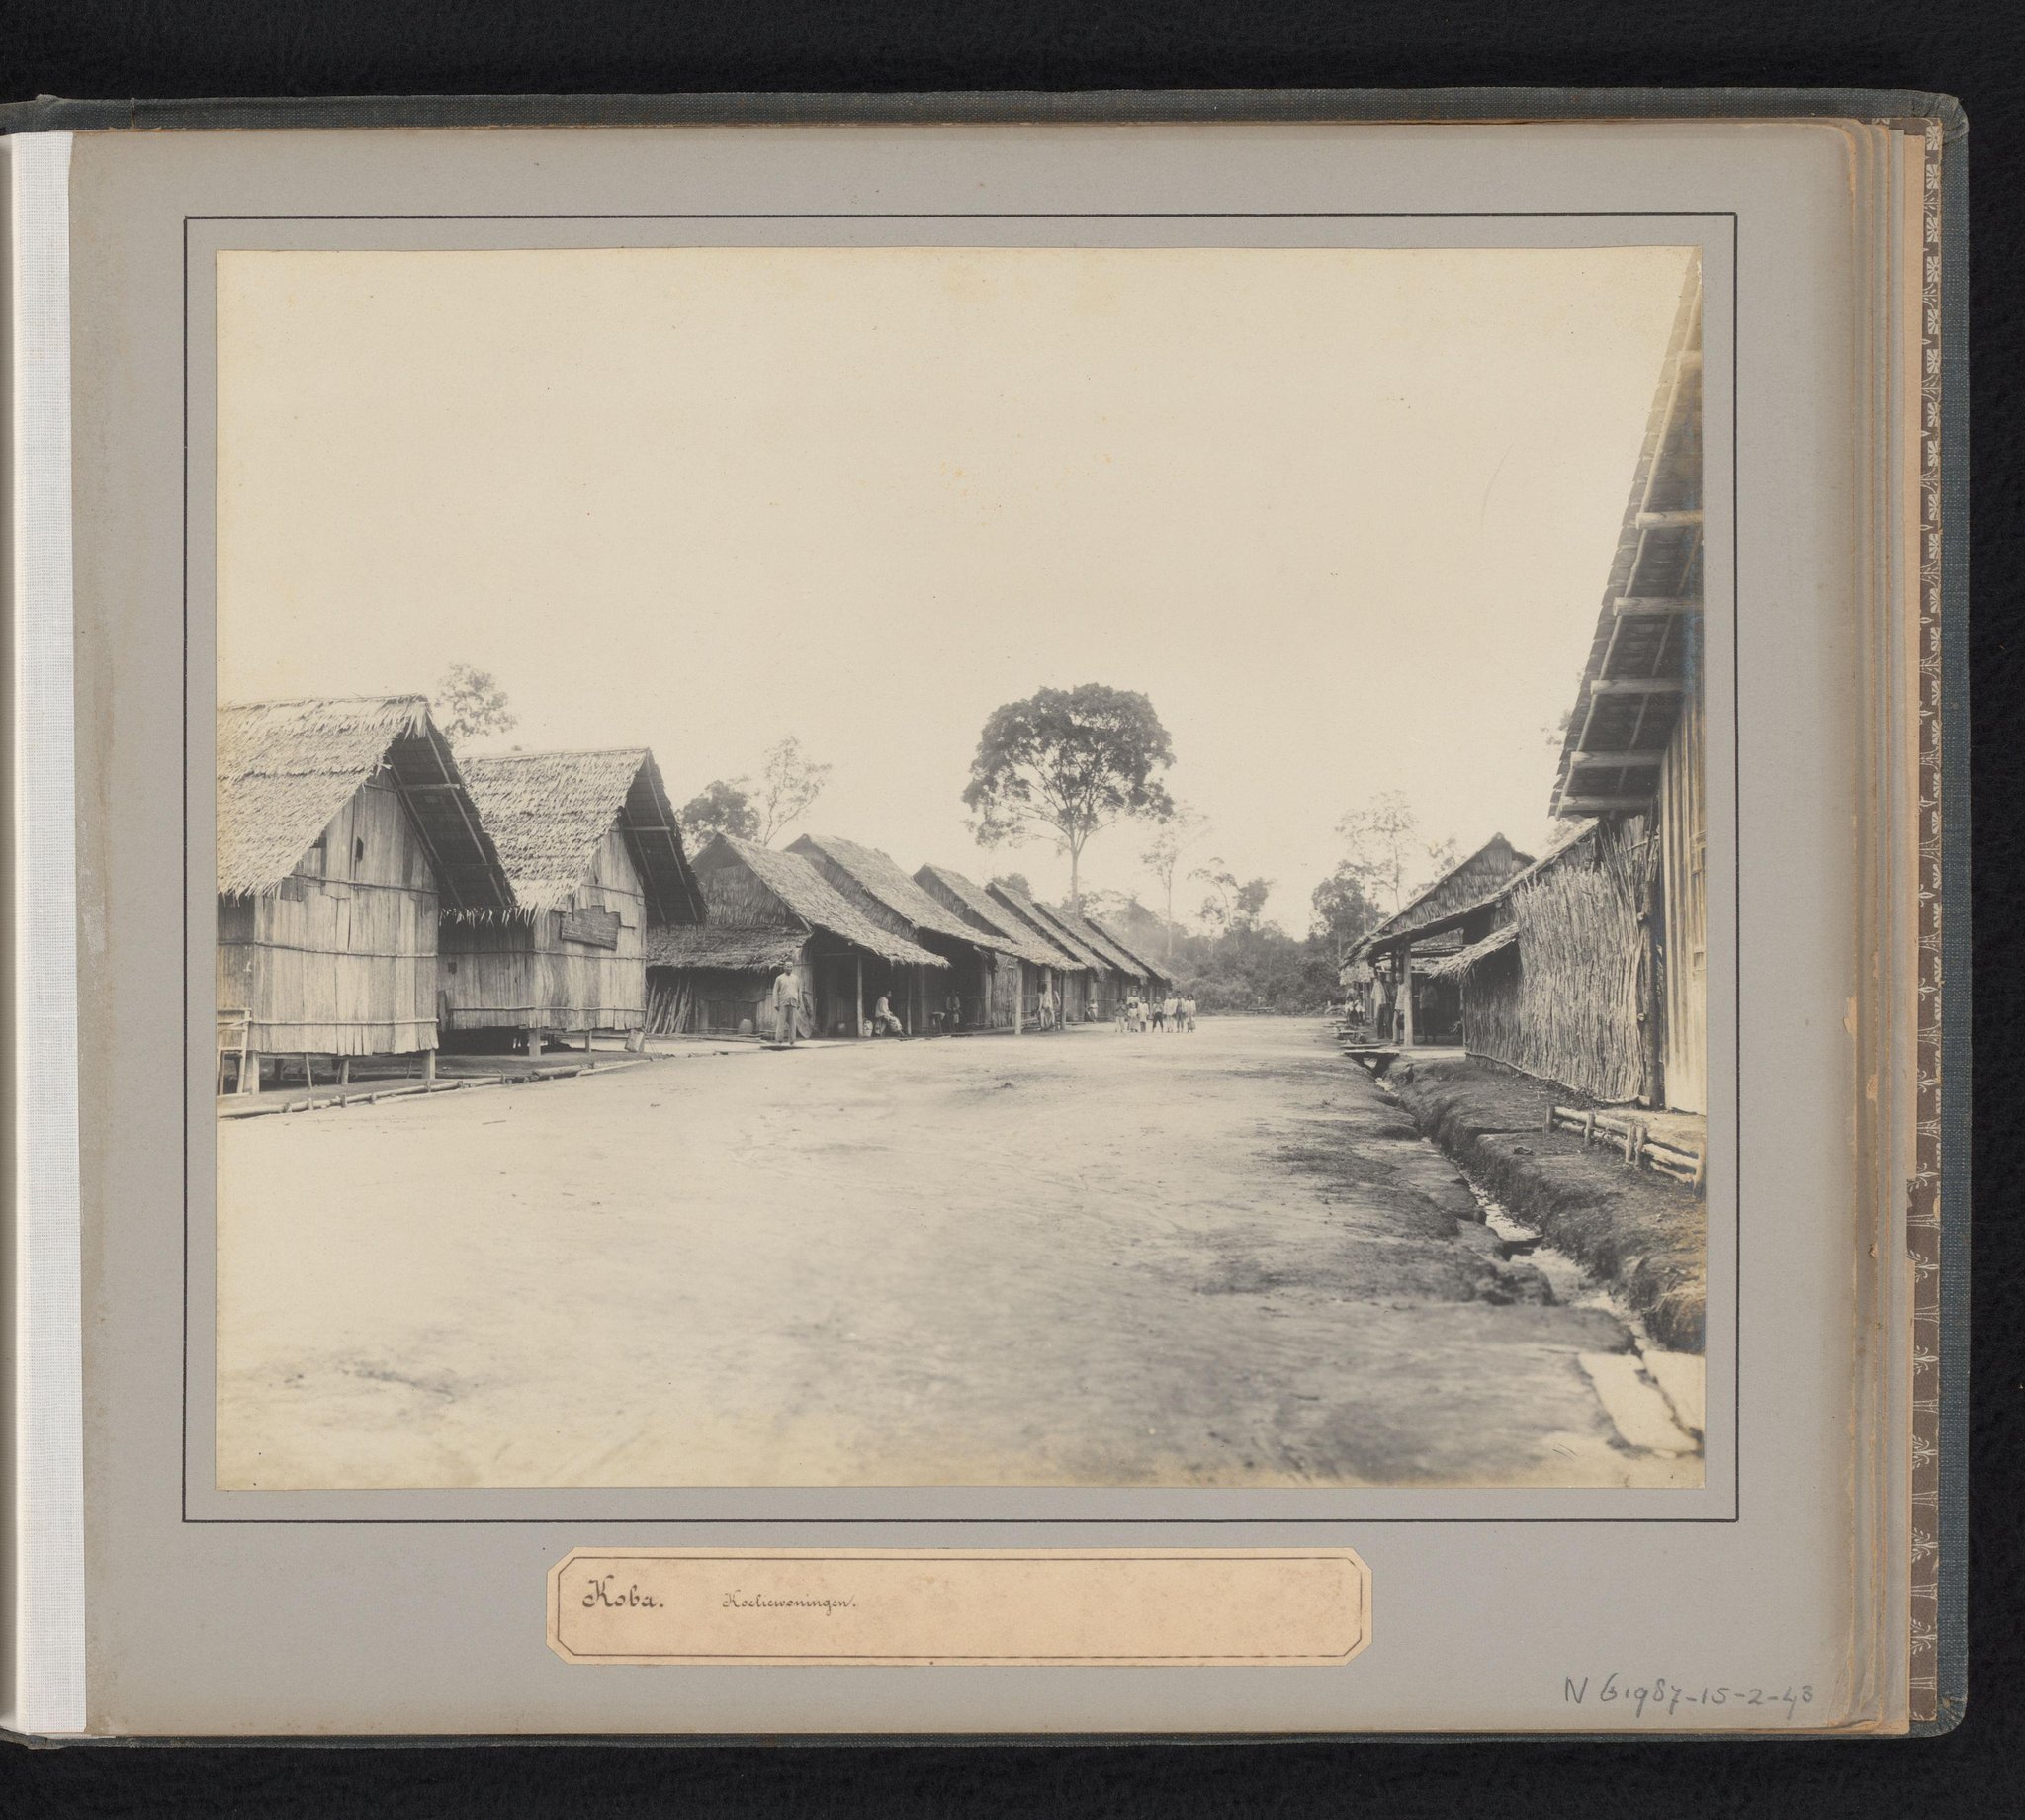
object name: photograph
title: Koba. Koeliewoningen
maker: Anonymous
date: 1907-1919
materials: cardboard, photographic support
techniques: gelatin silver print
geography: bangka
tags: robert julius boers, colonial system, miner, minerals and metals: tin, working class, labourers, mine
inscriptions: label: ‘Koba. Koeliewoningen’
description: Kampement met woningen voor de Chinese contractarbeiders van de Banka-tinwinning te Koba. Op straat een groepje Chinese kinderen. Onderdeel van het fotoalbum over de Banka-tinwinning, ca. 1907-1919.